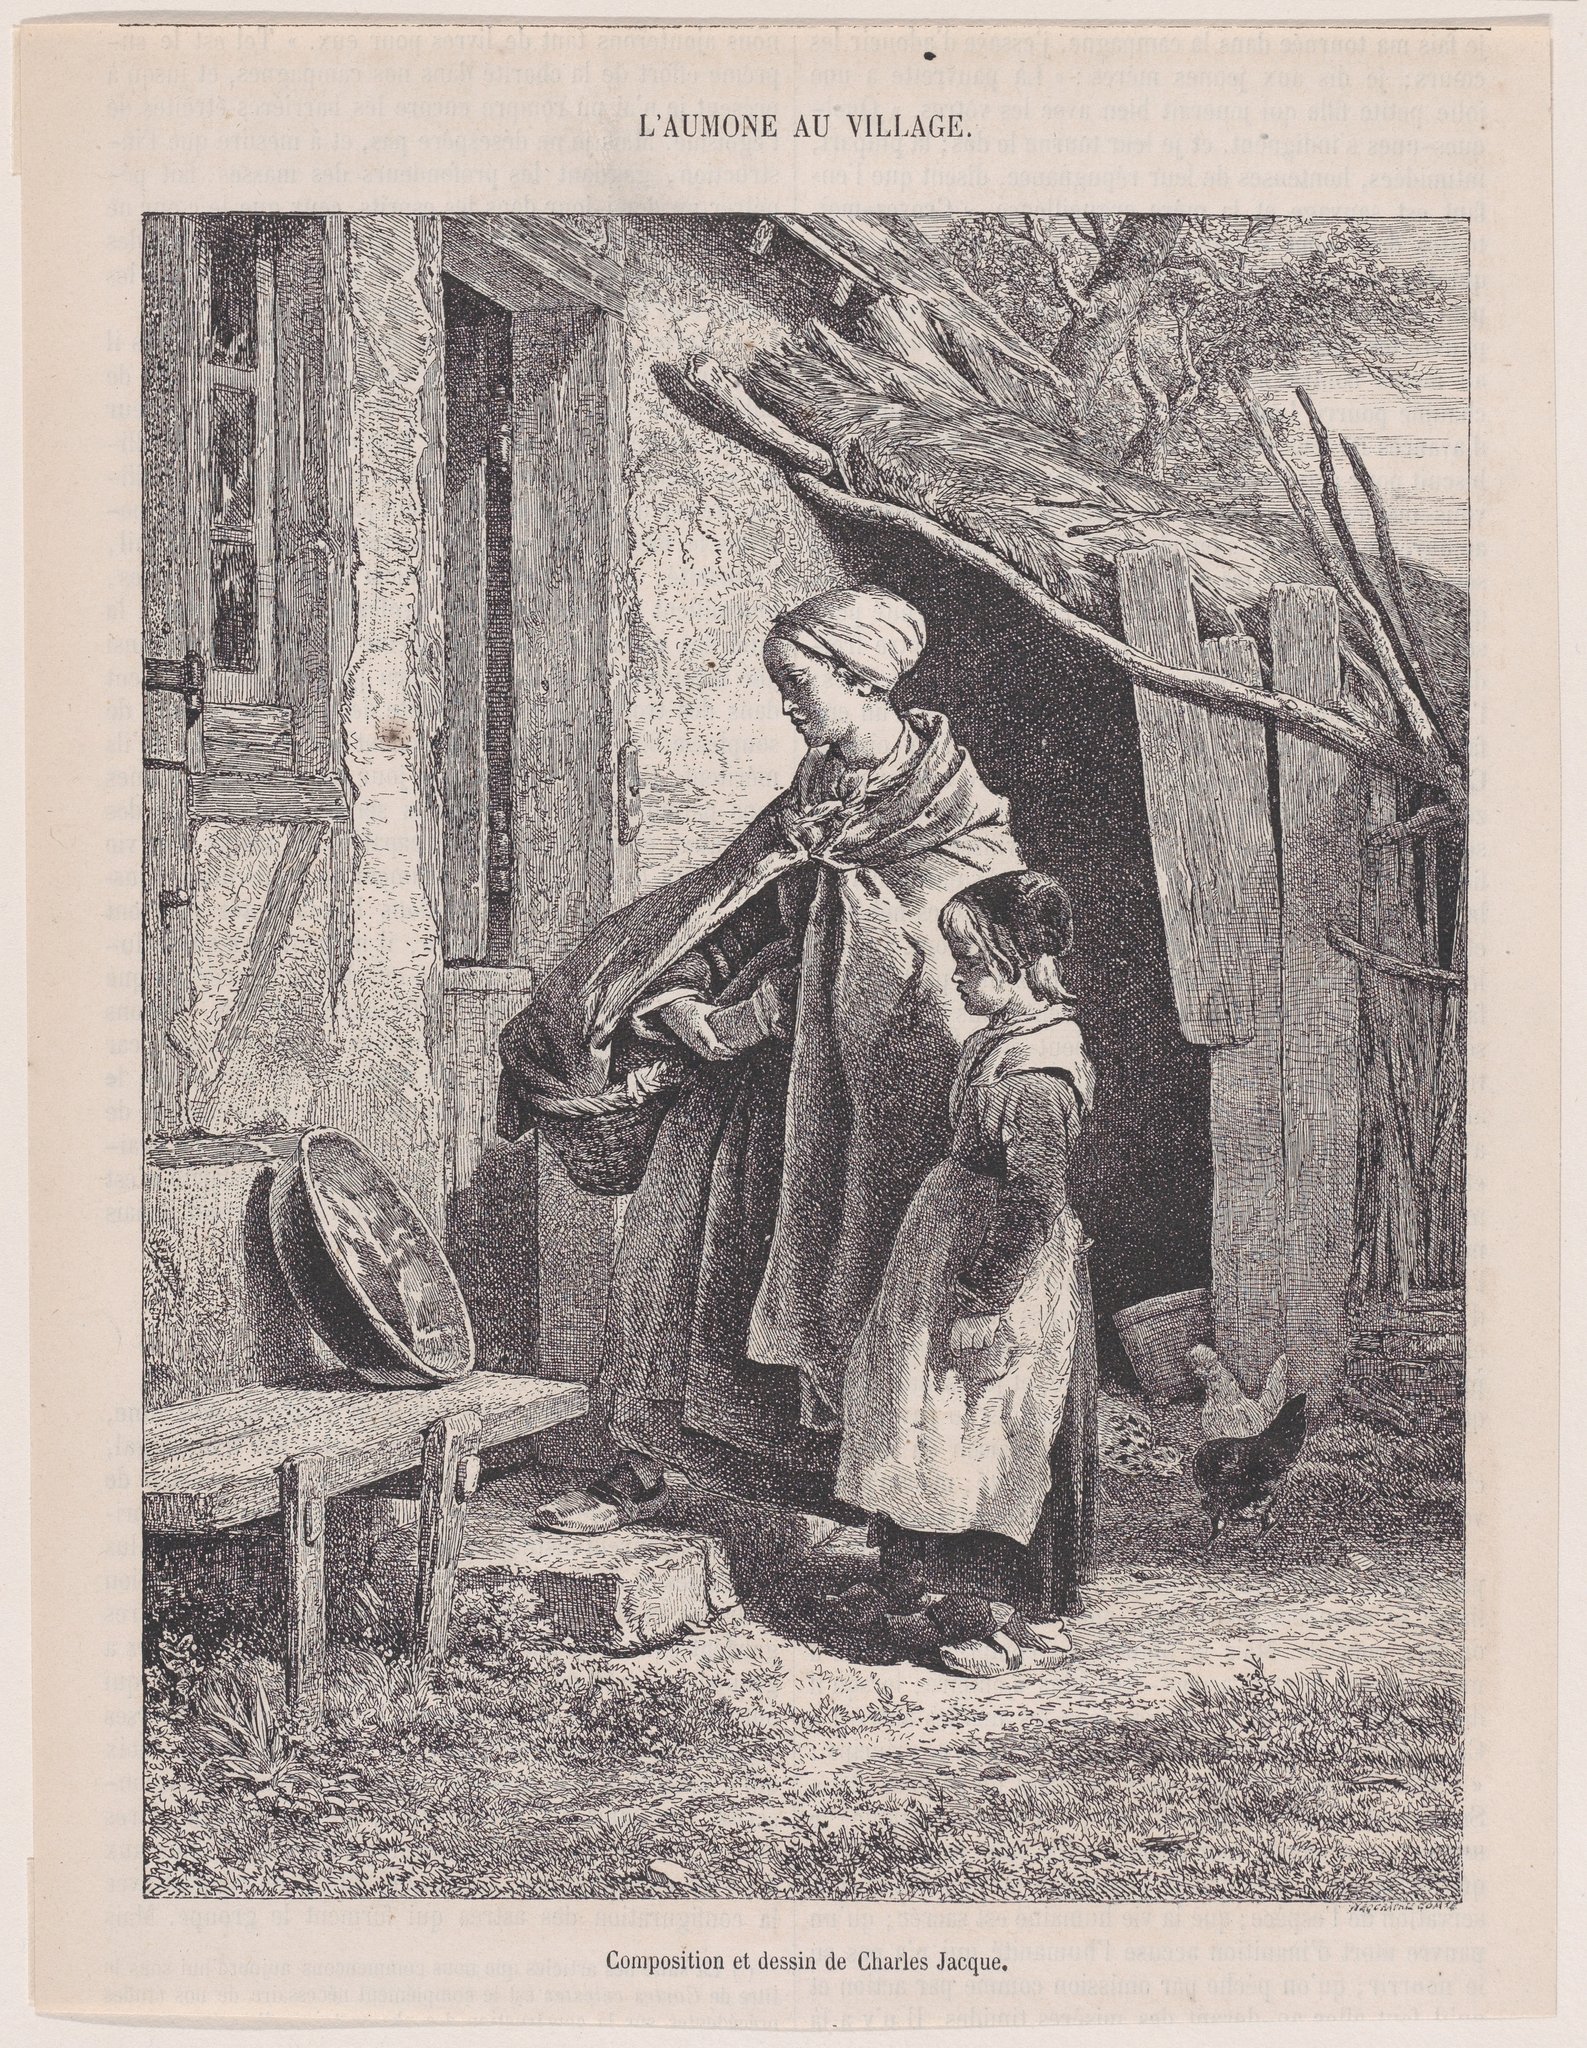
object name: print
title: Charity in the Village, from "Le Magasin Pittoresque"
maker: charles émile jacque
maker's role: artist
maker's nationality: french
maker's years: 1813-1894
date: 1862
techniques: relief print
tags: girls